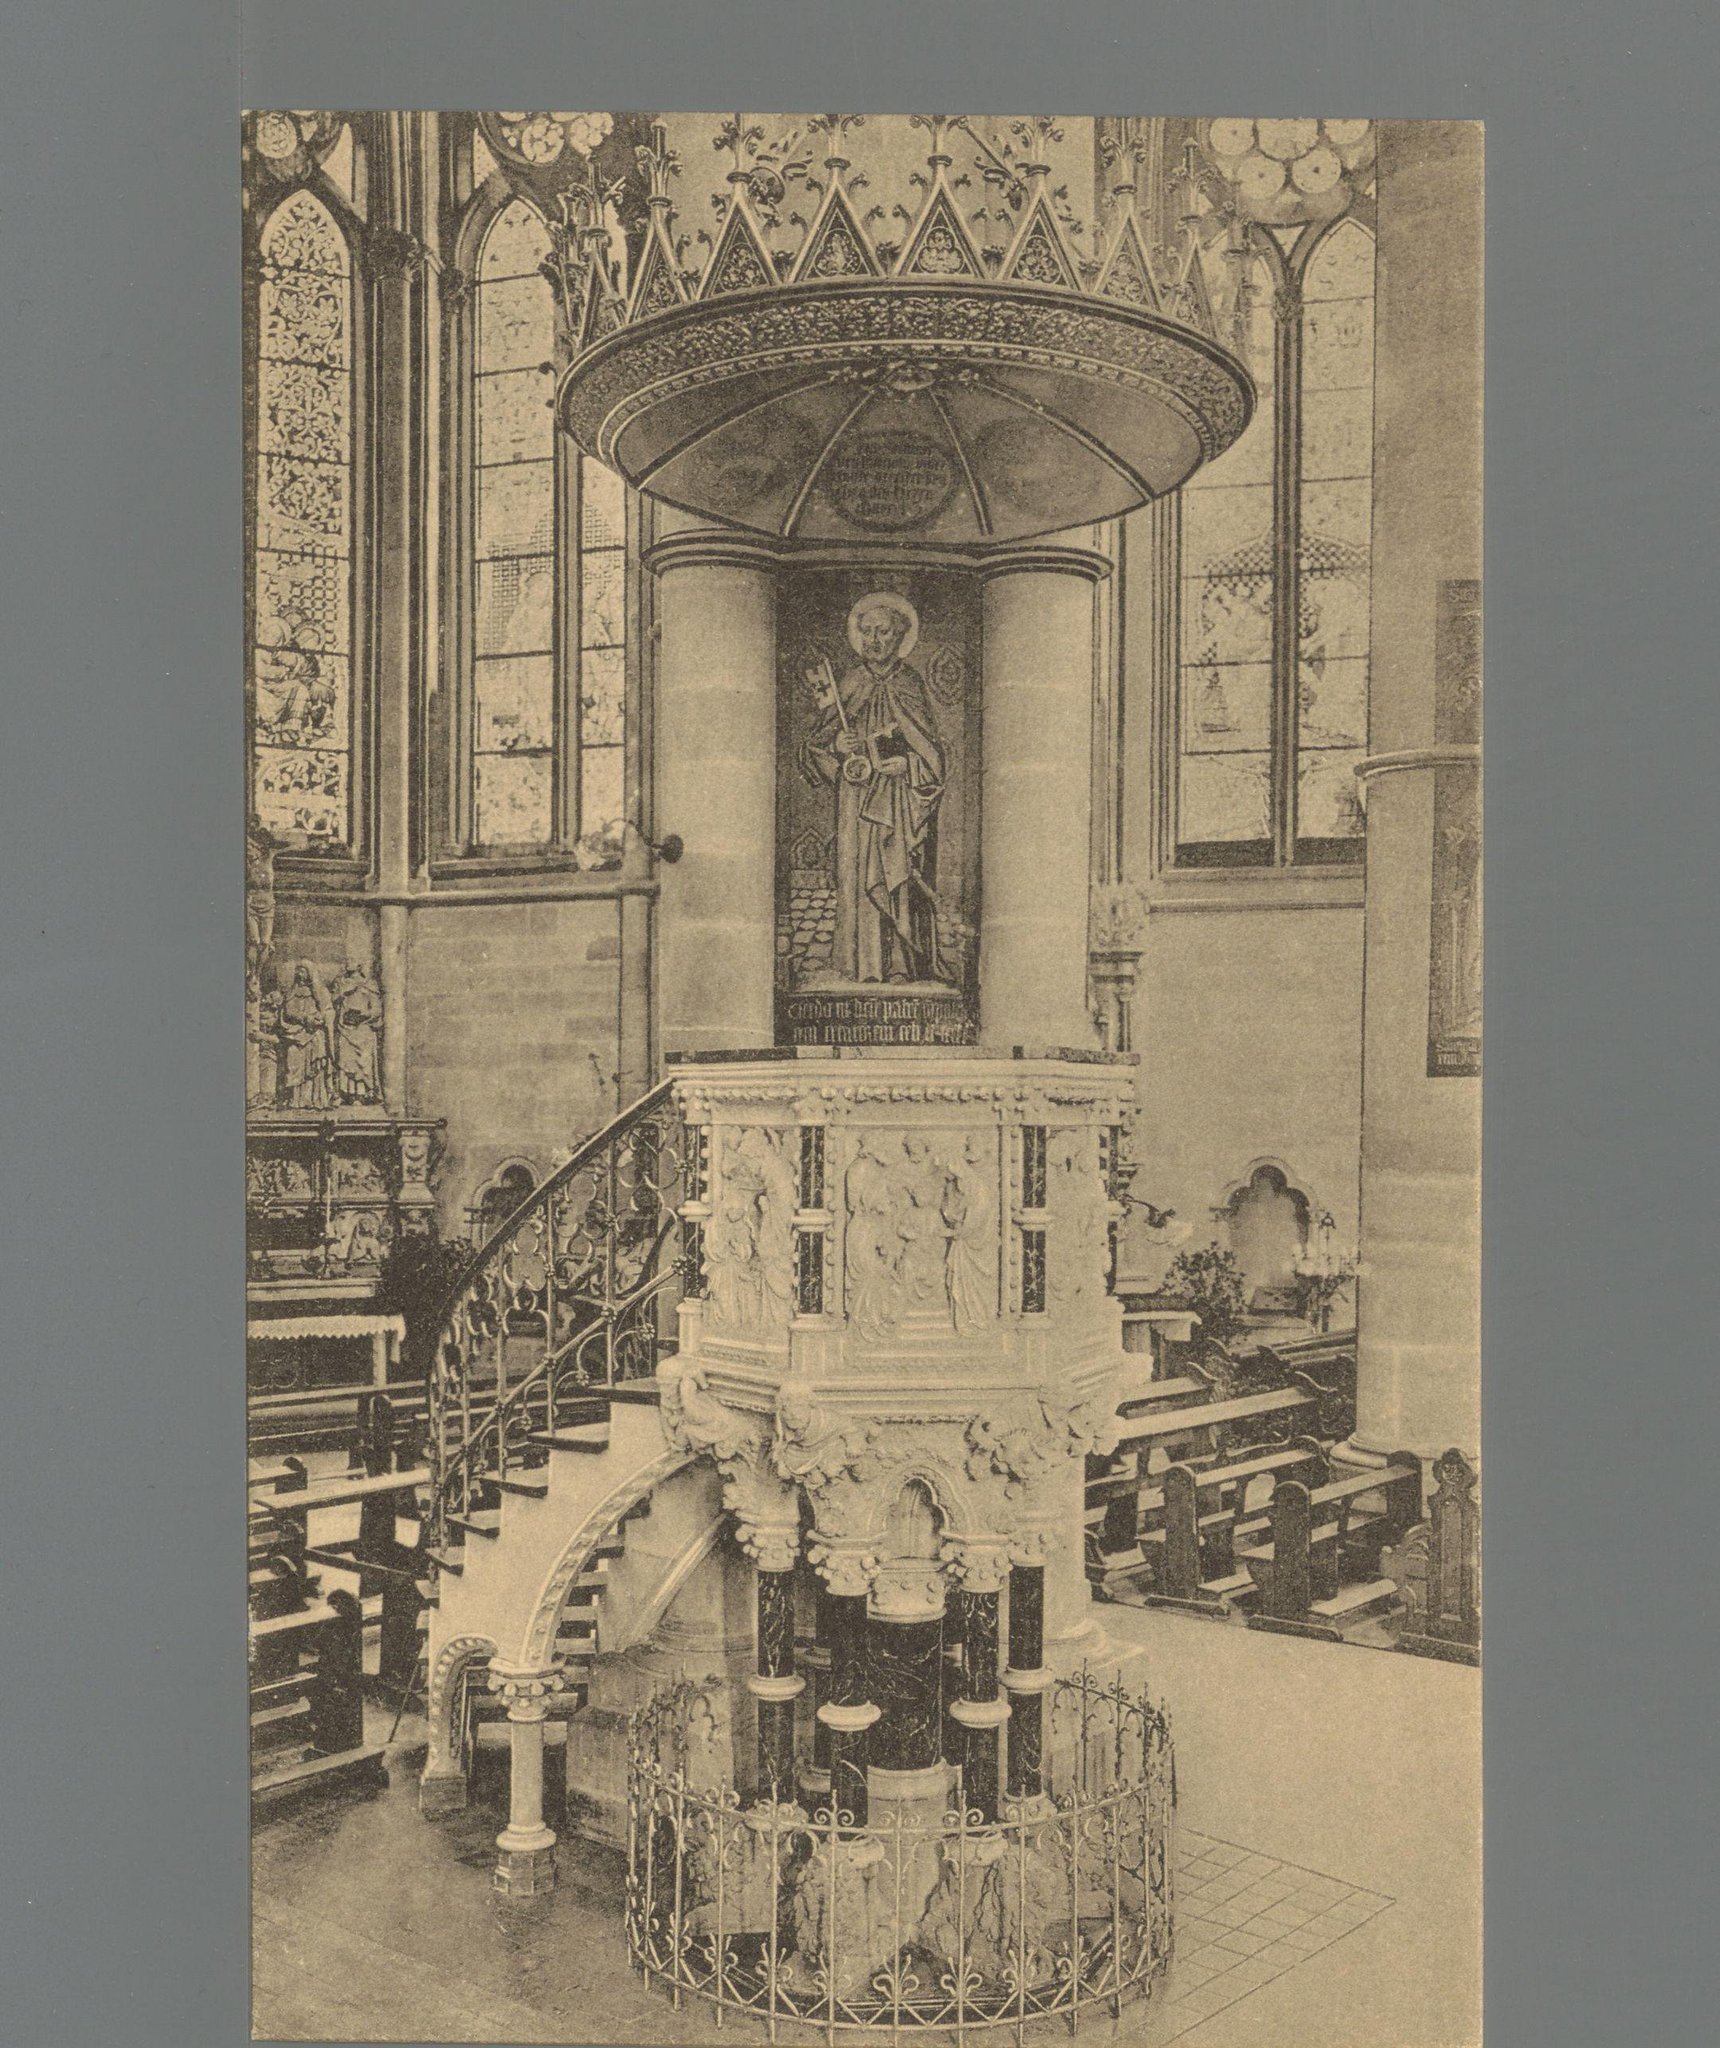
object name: ansichtkaart, prentbriefkaart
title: Trier. Liebfrauenkirche. Neue Kanzel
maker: Anonymous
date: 1905-1930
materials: cardboard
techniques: photograph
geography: trier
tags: interior of church, pulpit, ambo, chancel